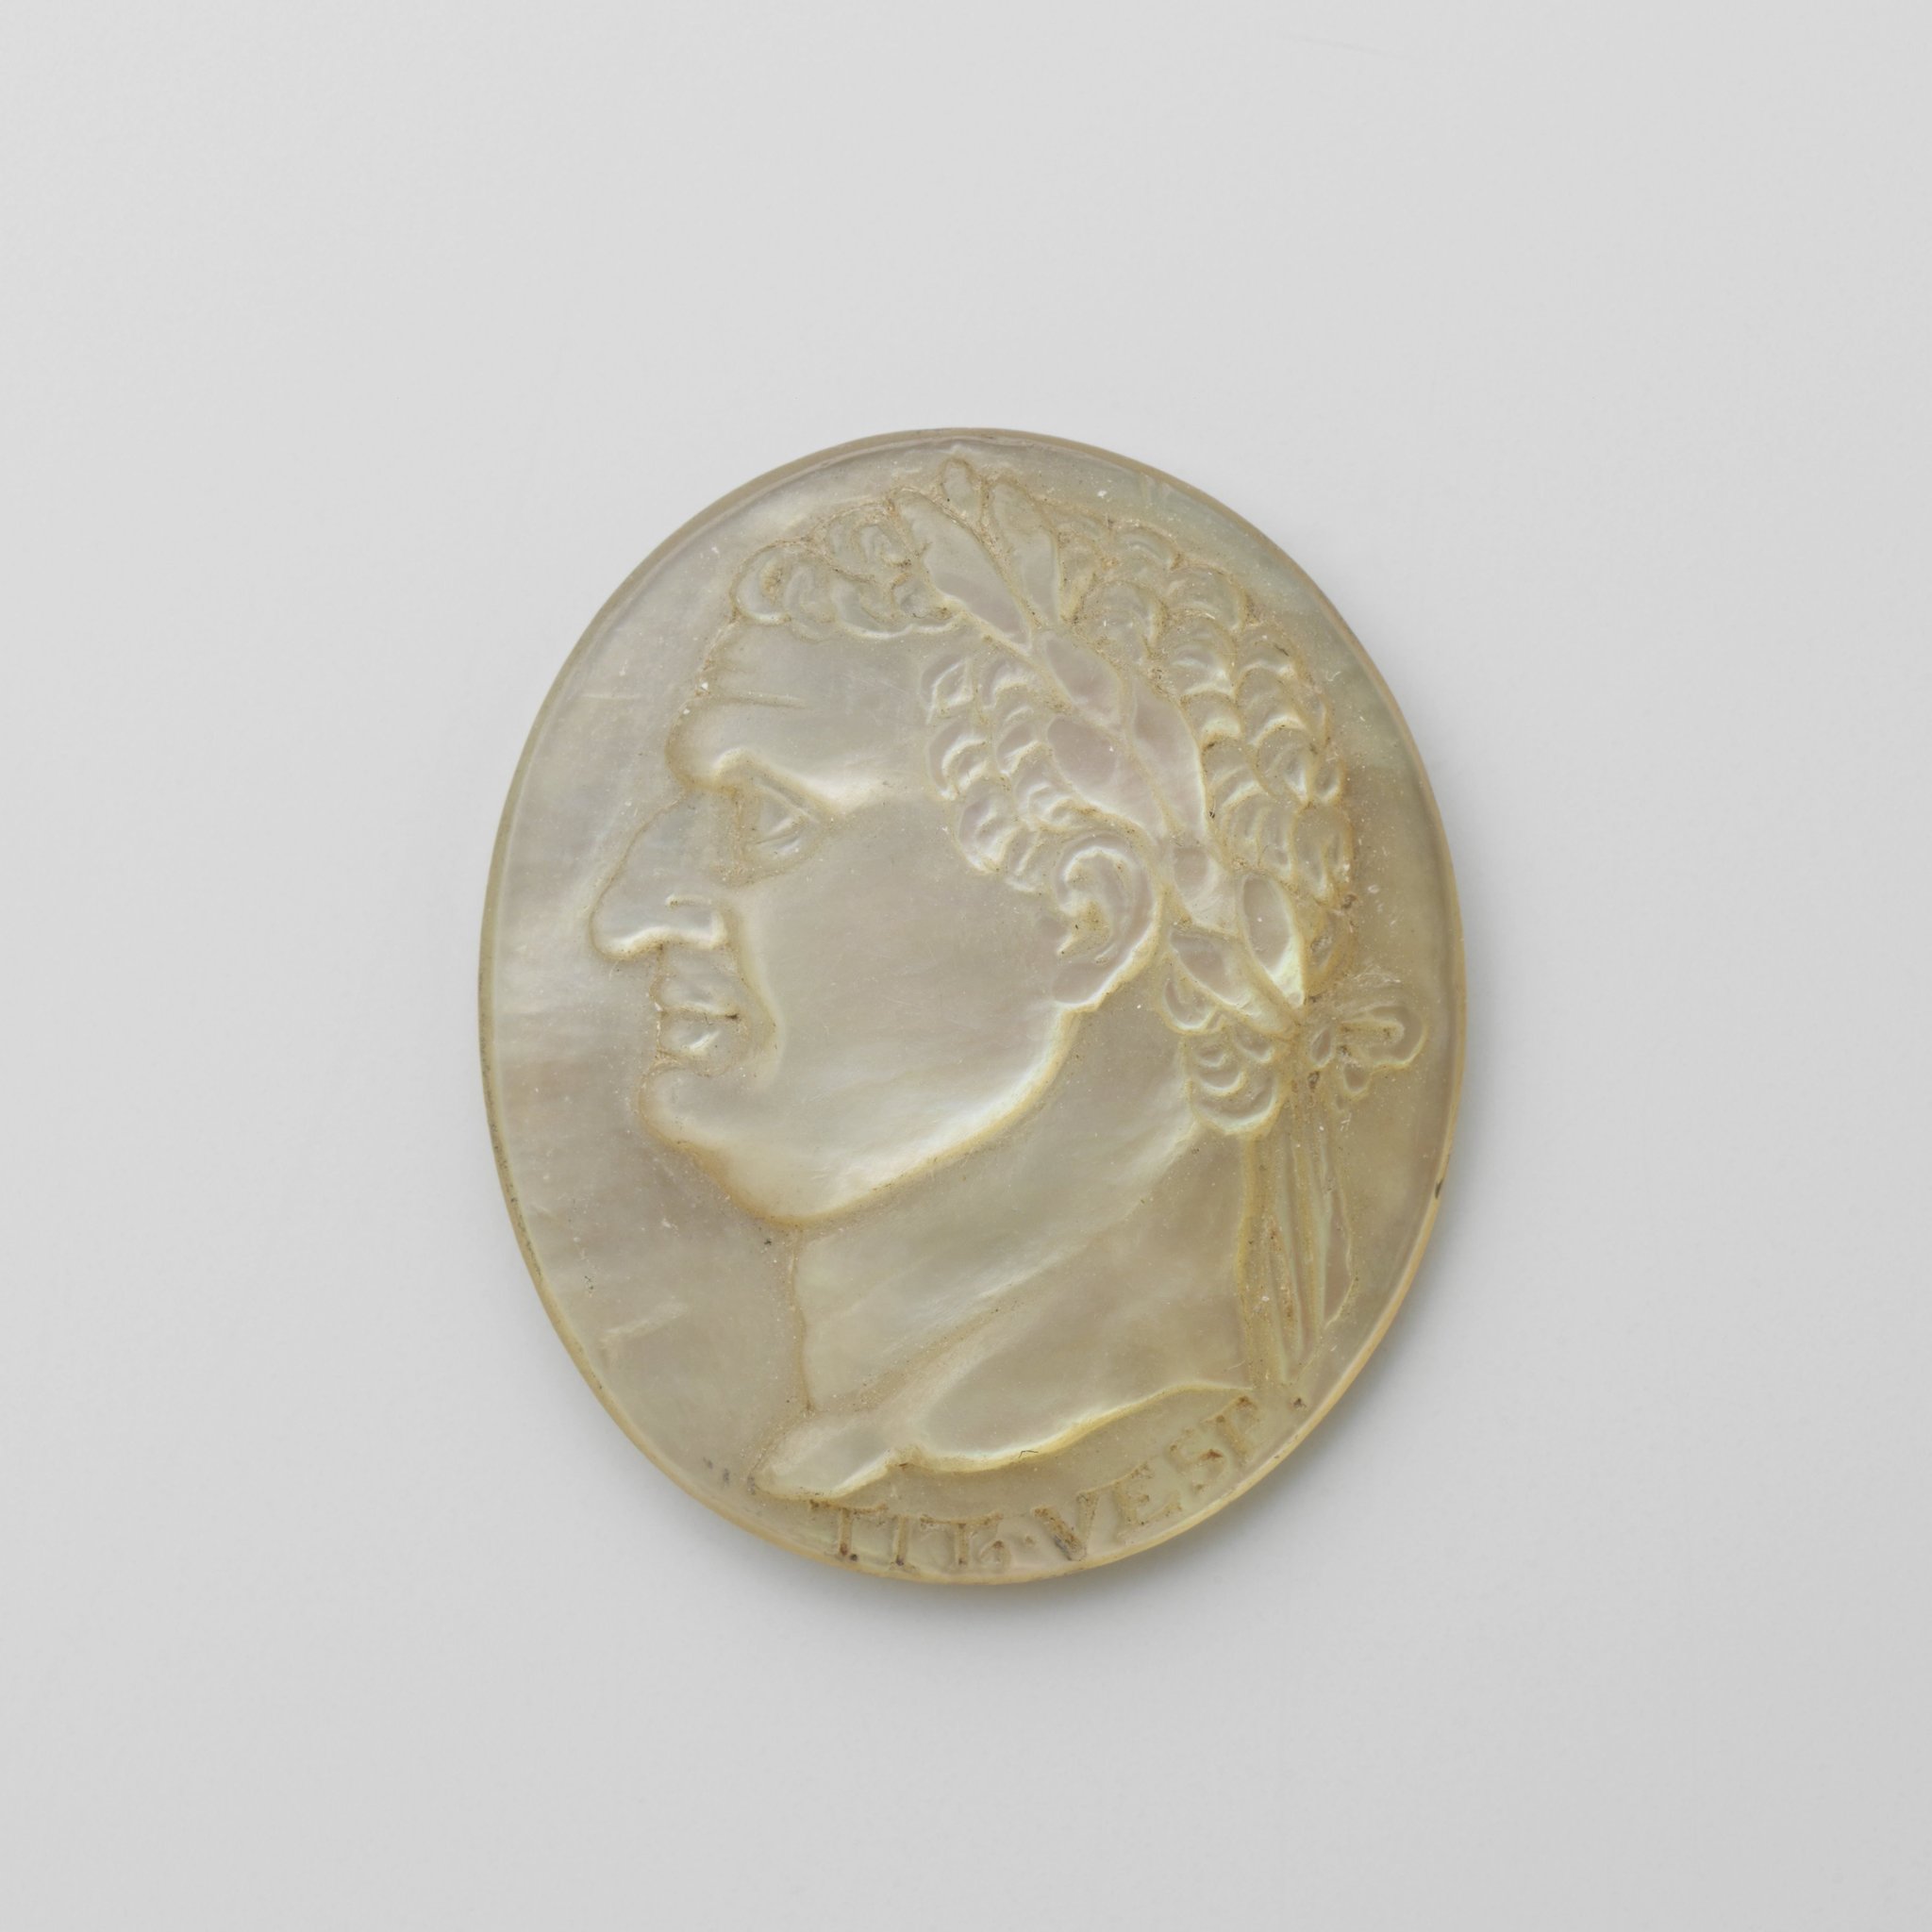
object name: locket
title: Titus Flavius Vespasianus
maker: Anonymous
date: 1700-1800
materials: mother of pearl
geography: netherlands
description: Een medaillon van parelmoer, waarop een afbeelding is gesneden van een Romeinse keizer, met randschrift: VESPASI.